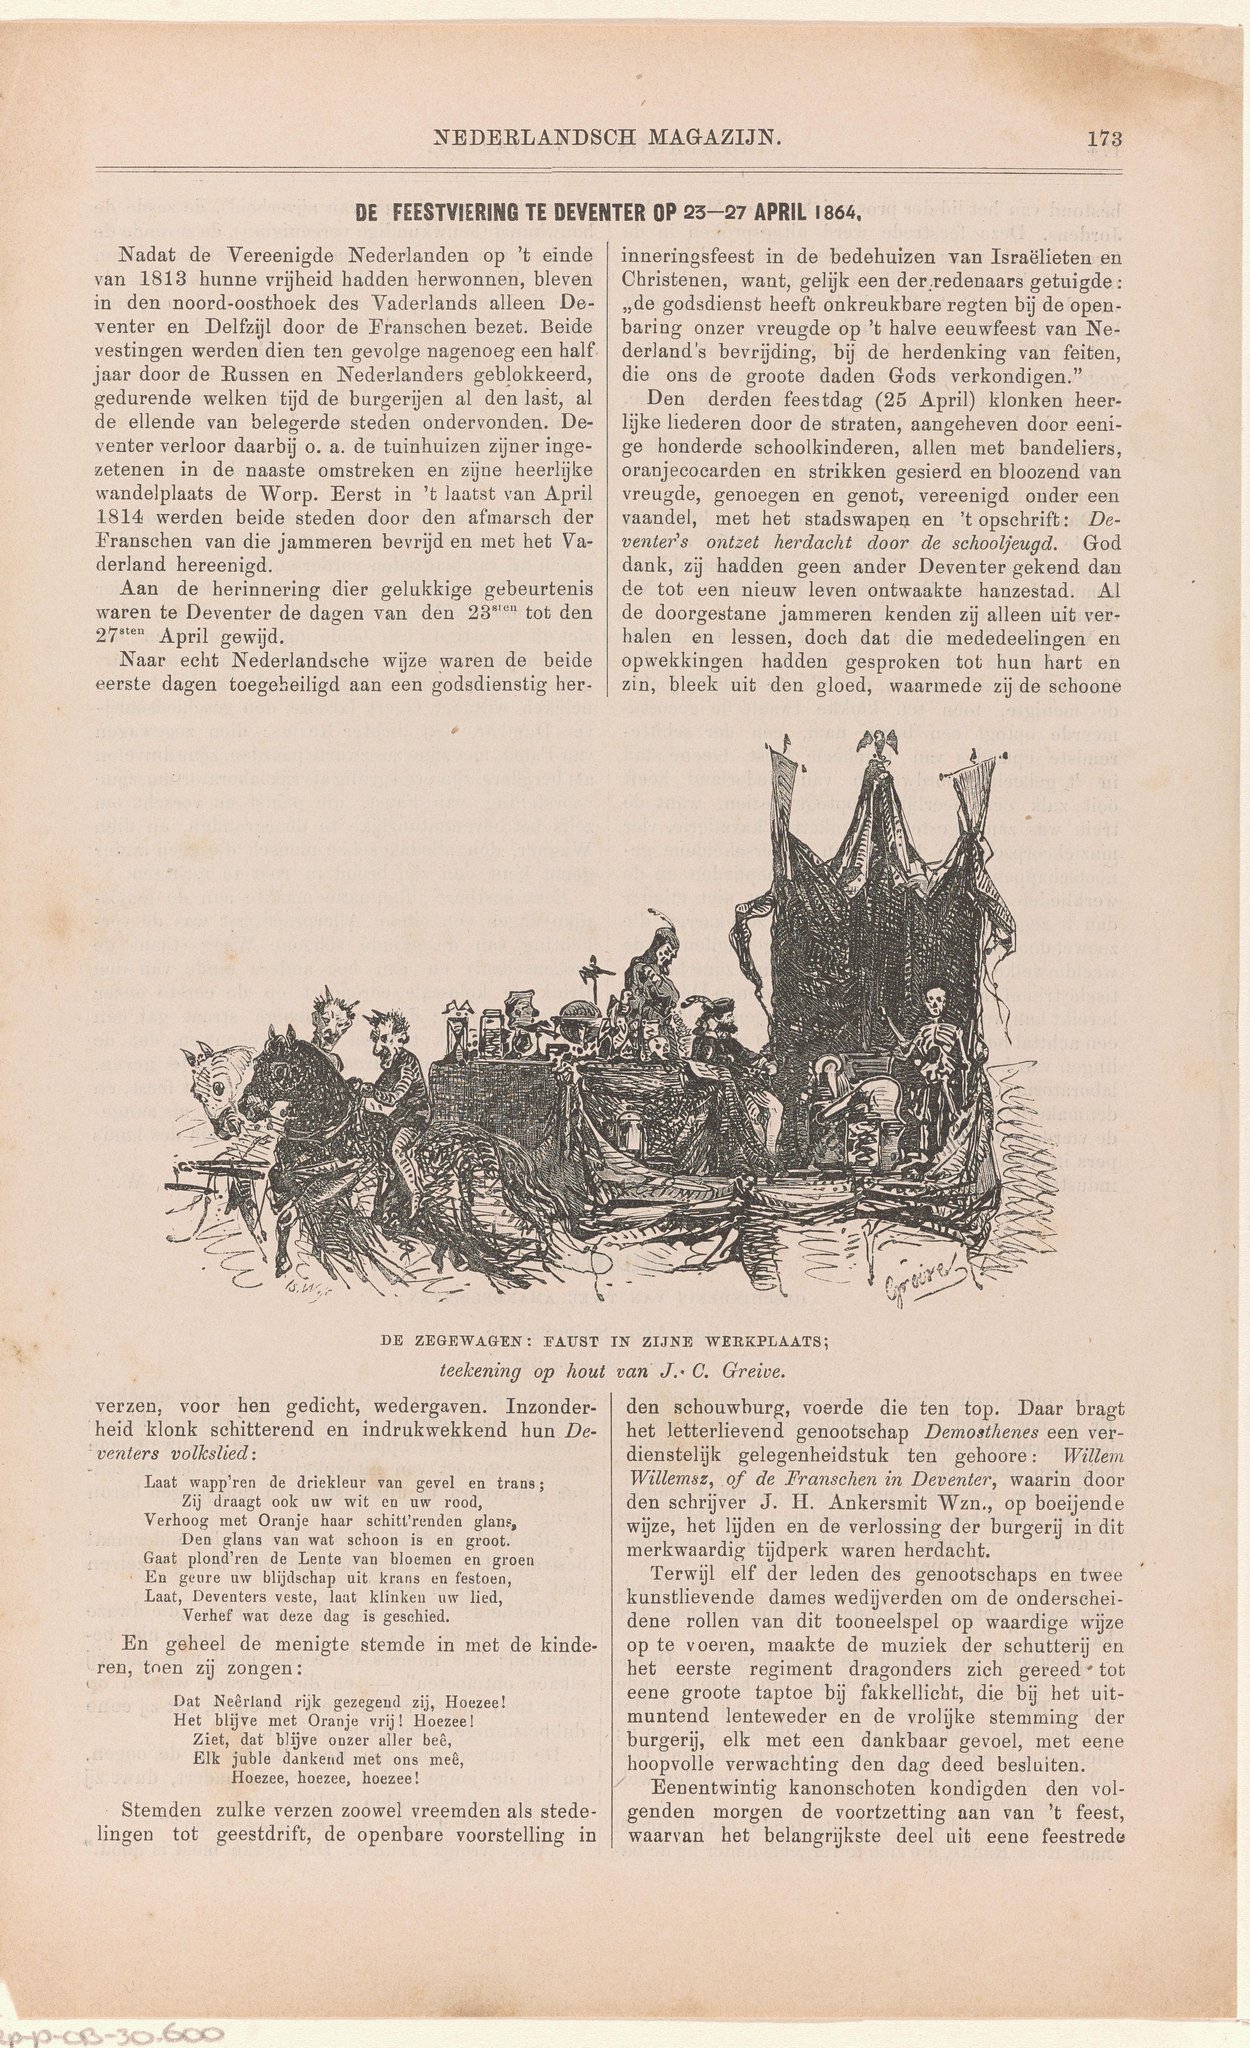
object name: book illustration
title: Optocht te Deventer op 26 april 1864 ter herinnering aan de bevrijding van Deventer op 26 april 1814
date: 1864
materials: paper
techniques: letterpress printing, engraving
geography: netherlands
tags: faust, deventer